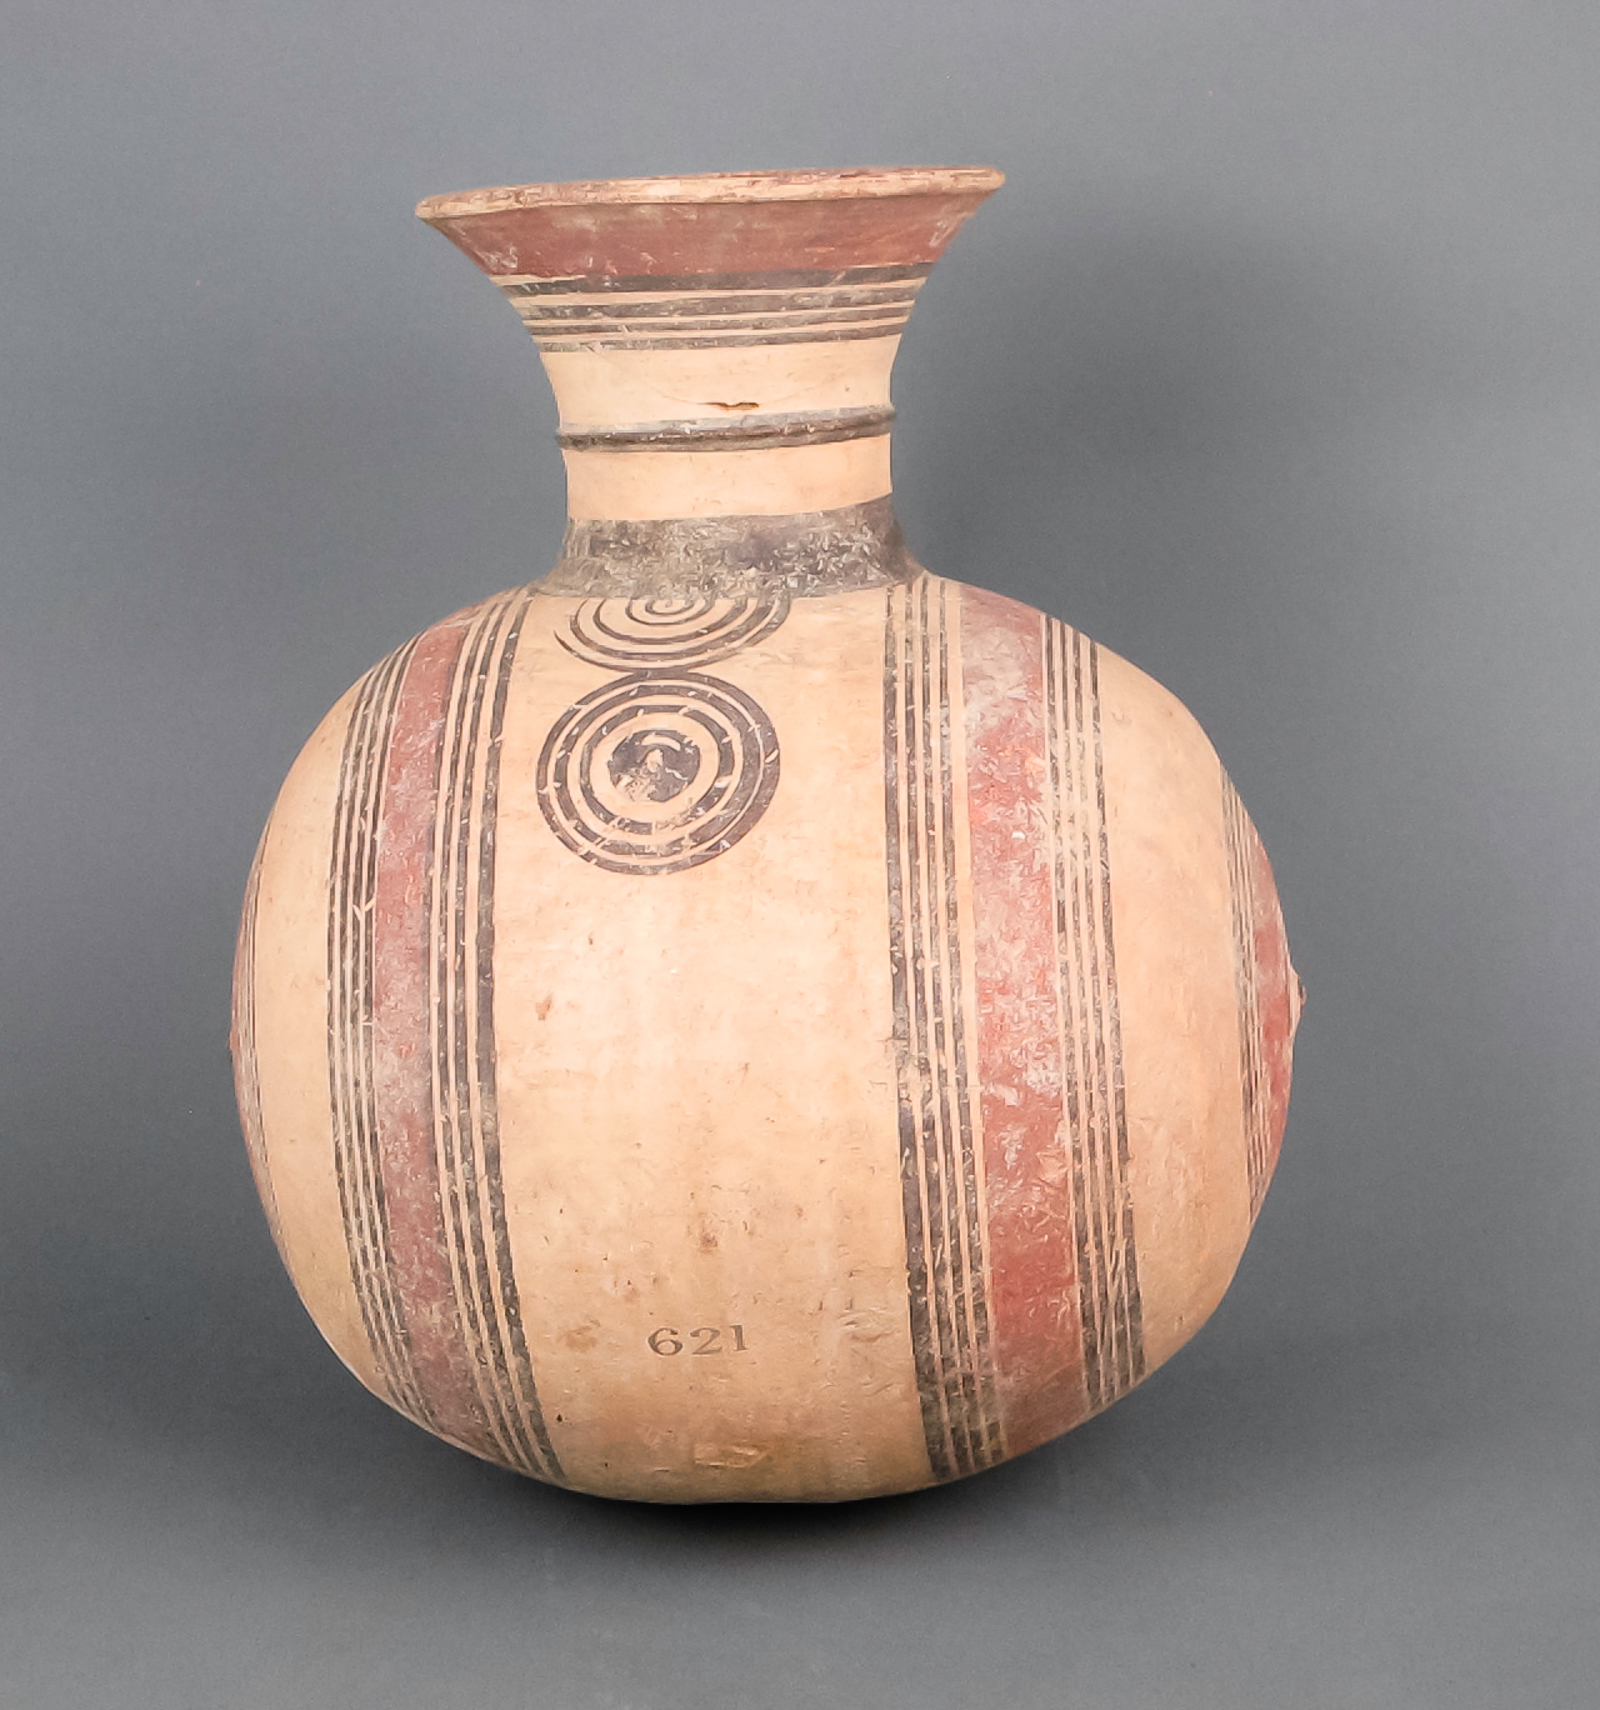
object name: jug, barrel shaped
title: Jug, barrel-shaped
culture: cypriot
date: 850-750 BCE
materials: terracotta